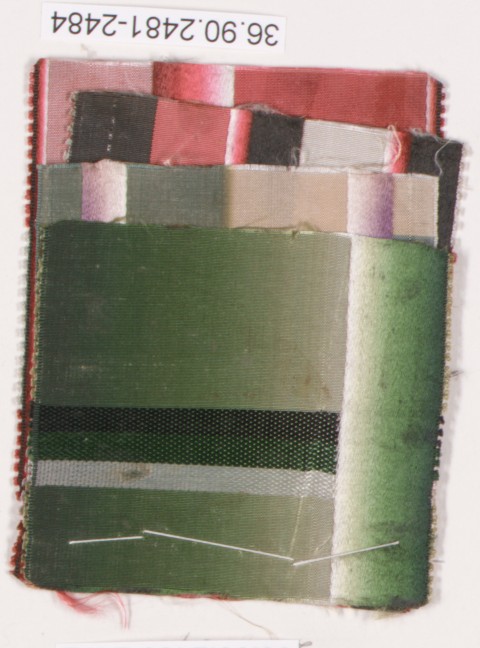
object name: ribbon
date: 1801-1900